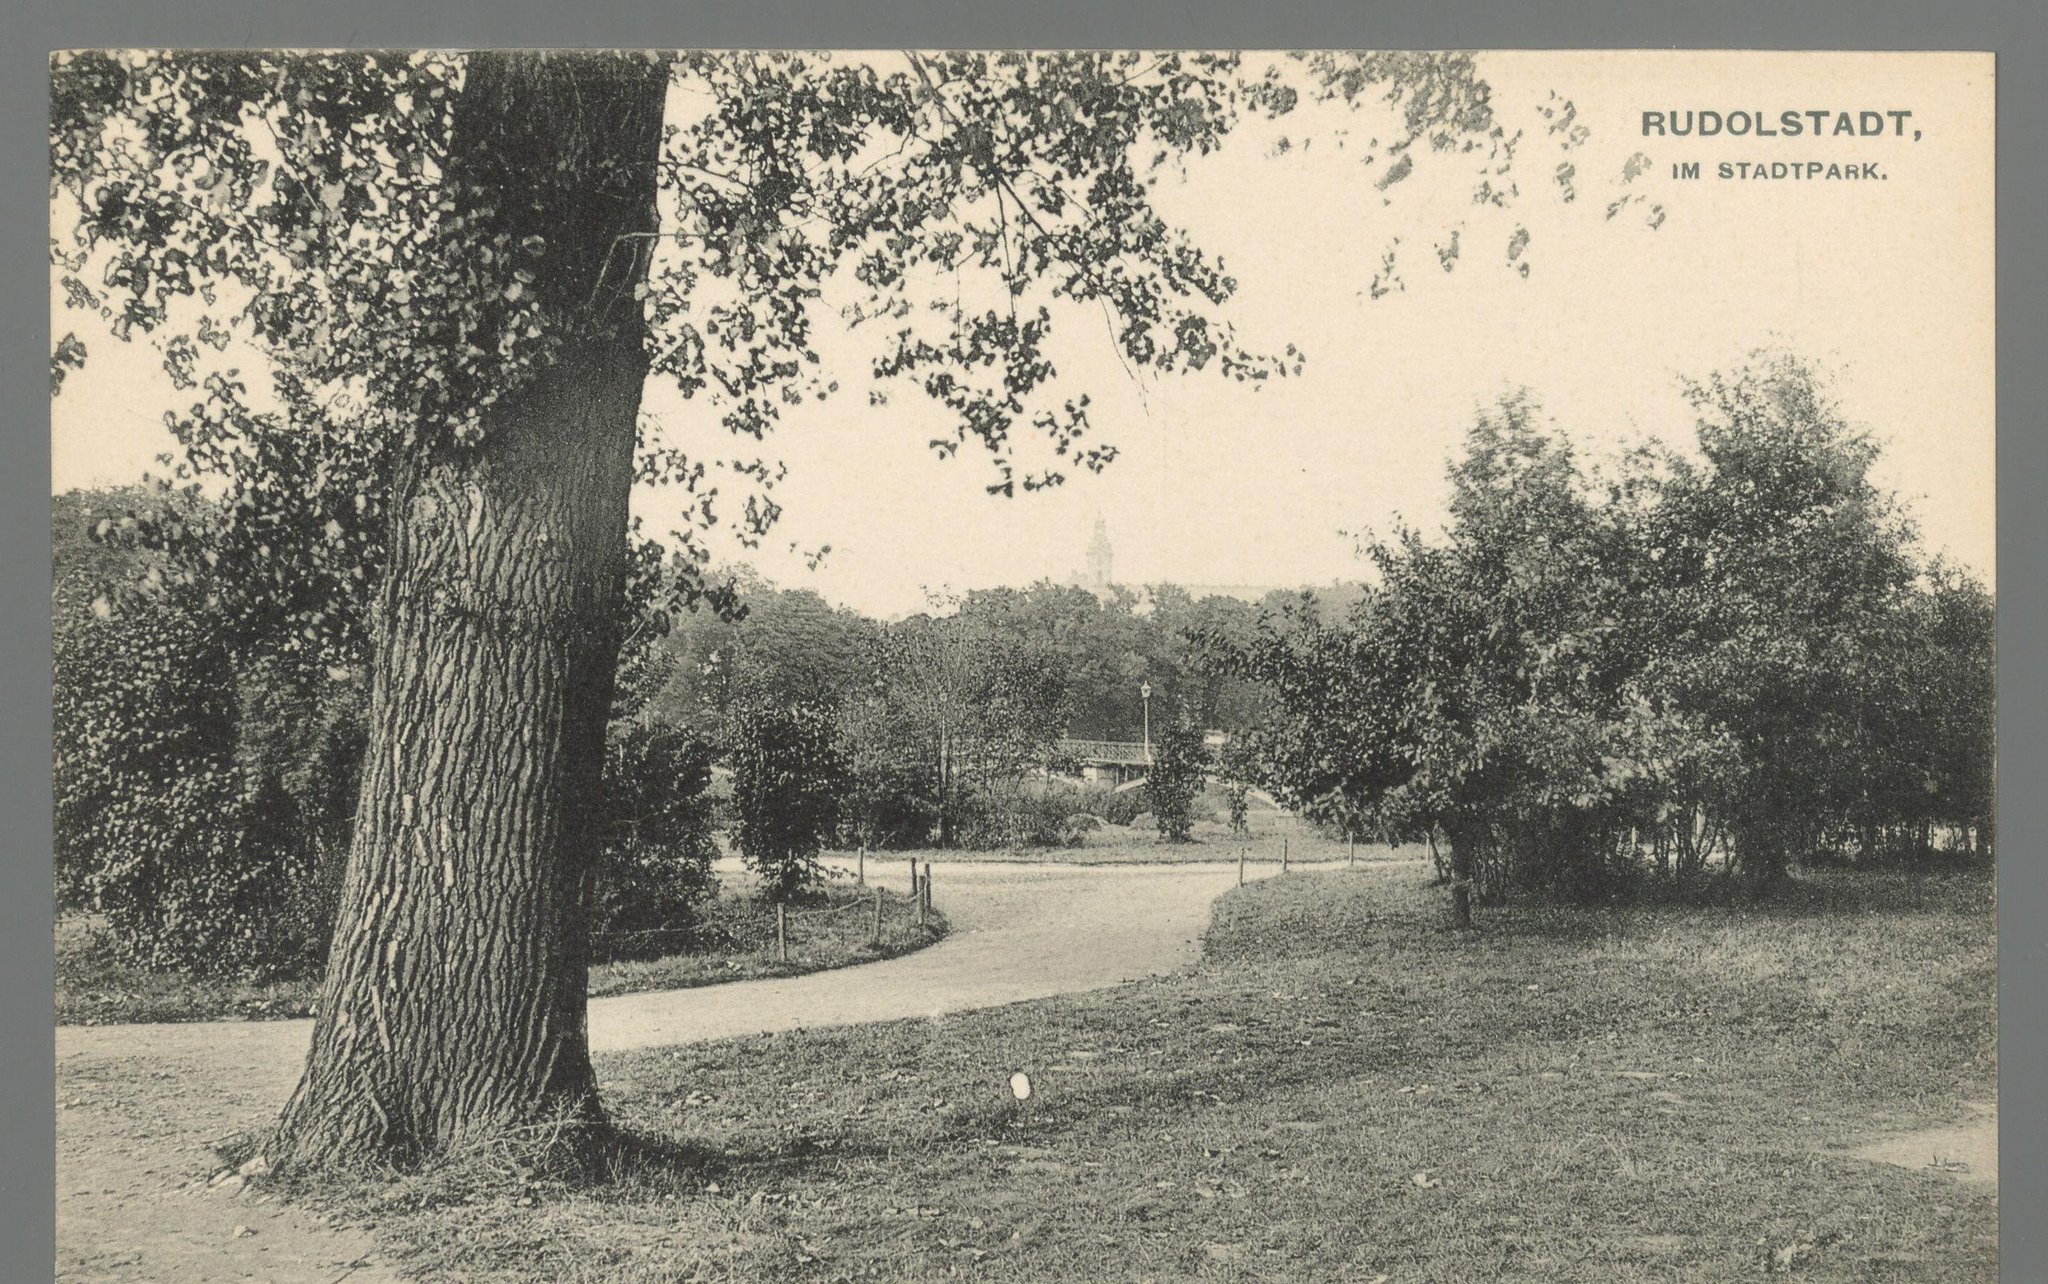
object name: photomechanical print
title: Rudolstadt, im Stadtpark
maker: Anonymous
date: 1907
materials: cardboard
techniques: photograph, writing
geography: darmstadt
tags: park, castle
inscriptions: date